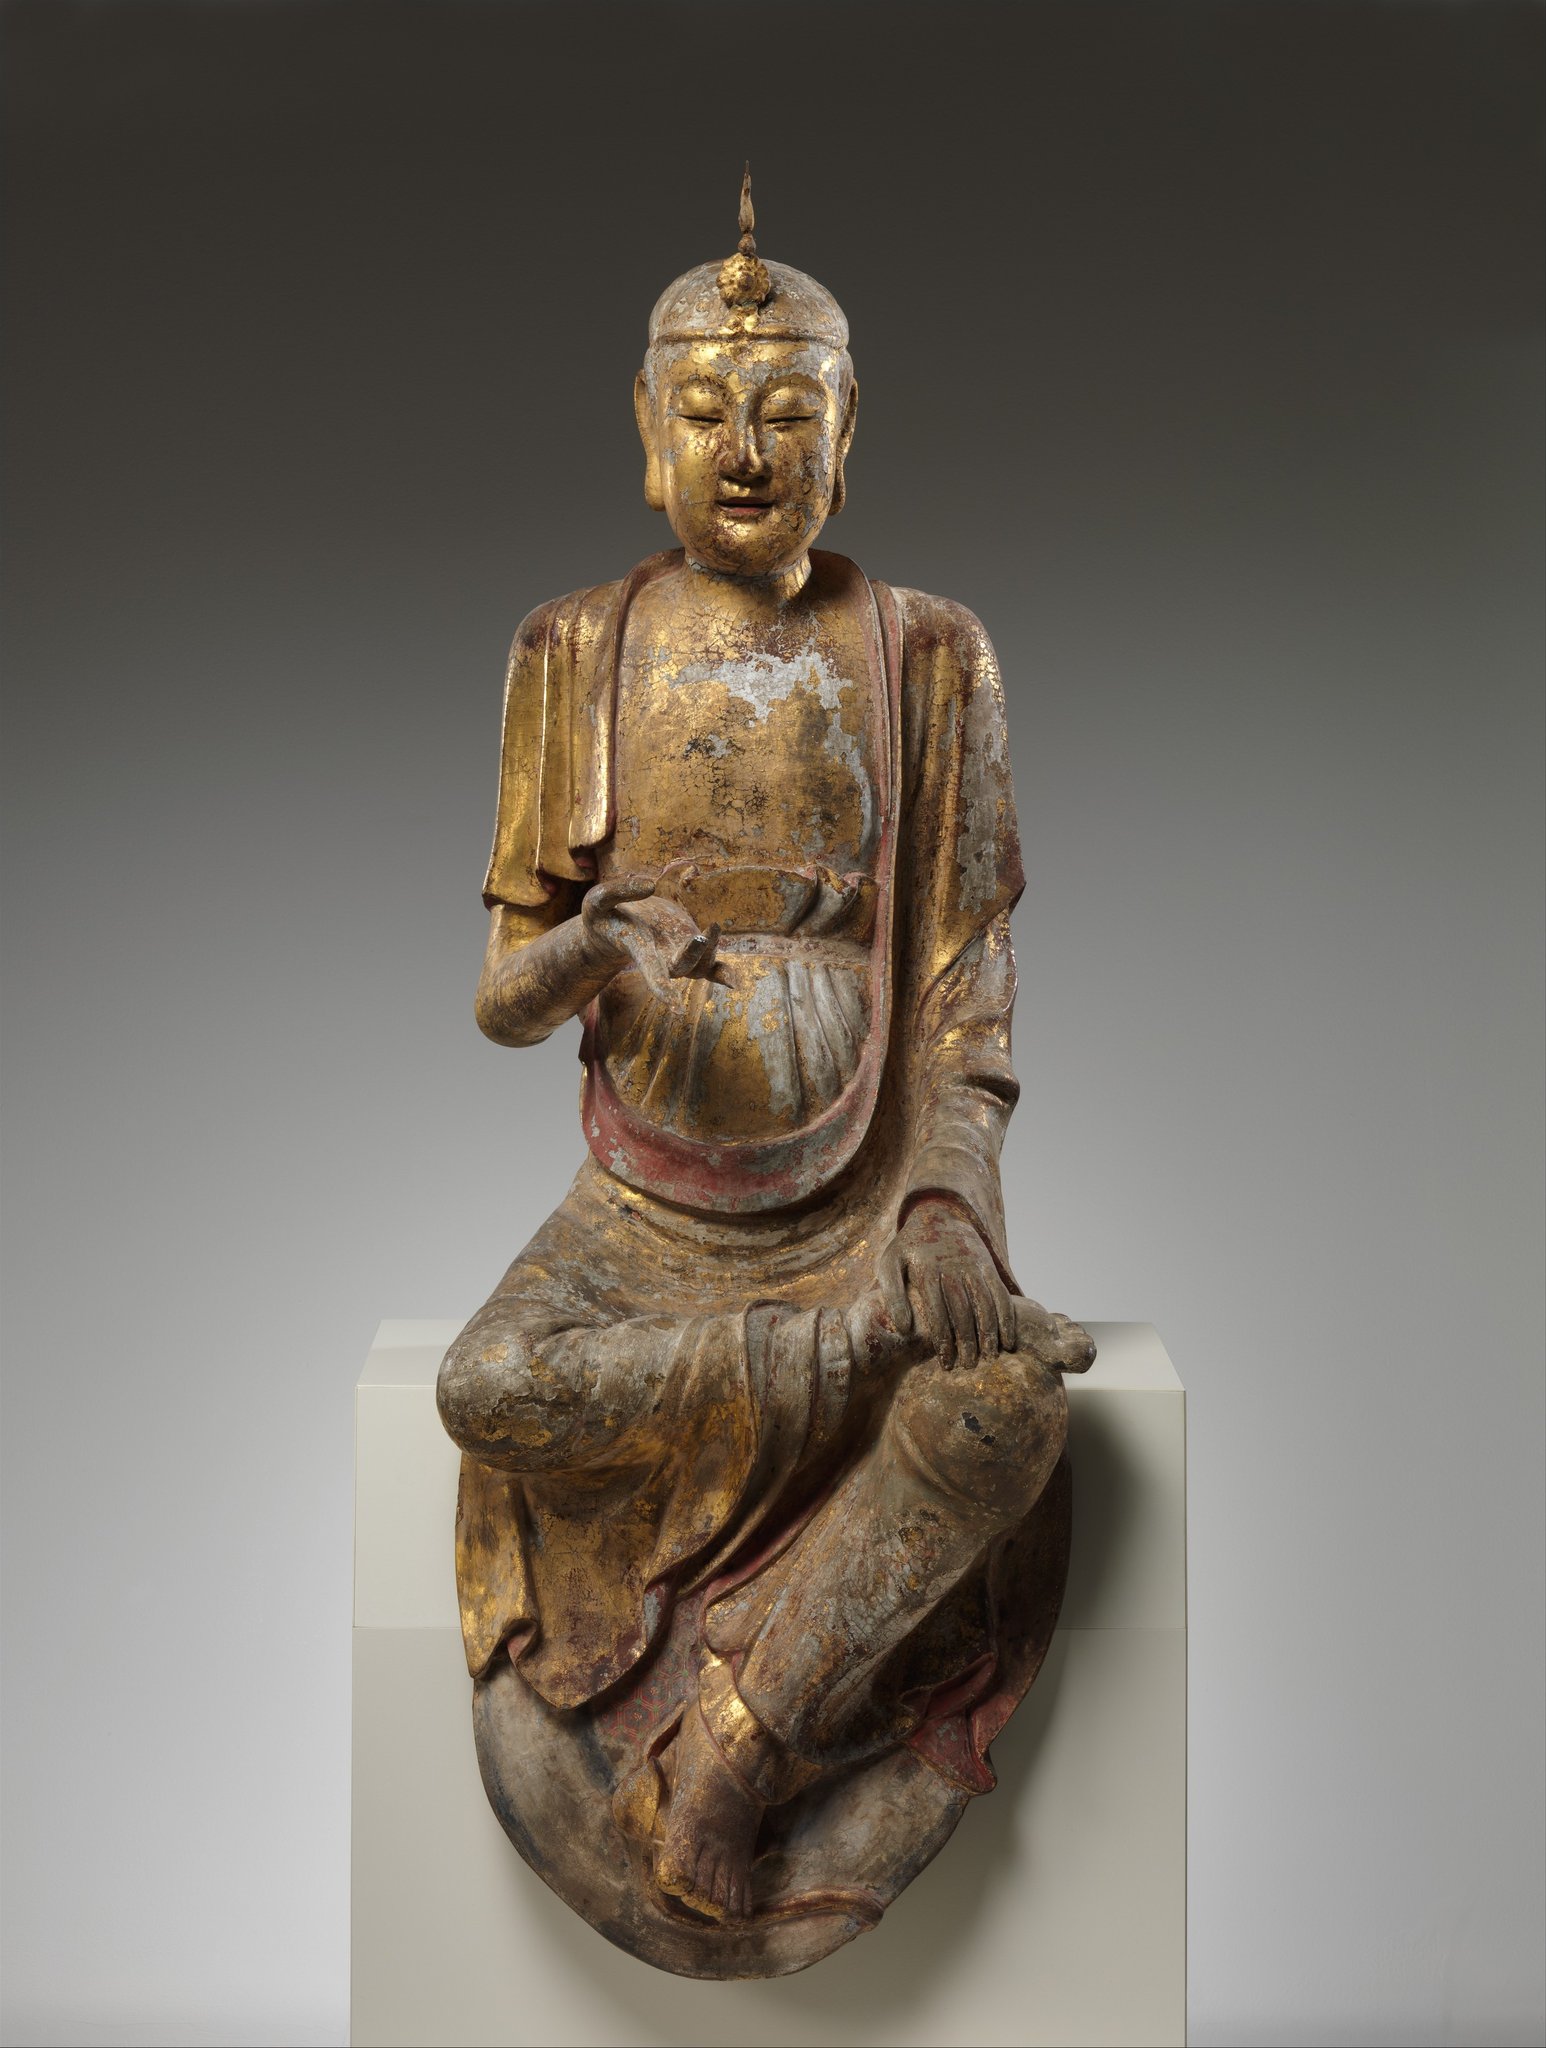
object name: figure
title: Bodhisattva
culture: chinese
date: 1501-1700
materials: lacquer, wood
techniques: gilding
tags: buddhism,bodhisattvas